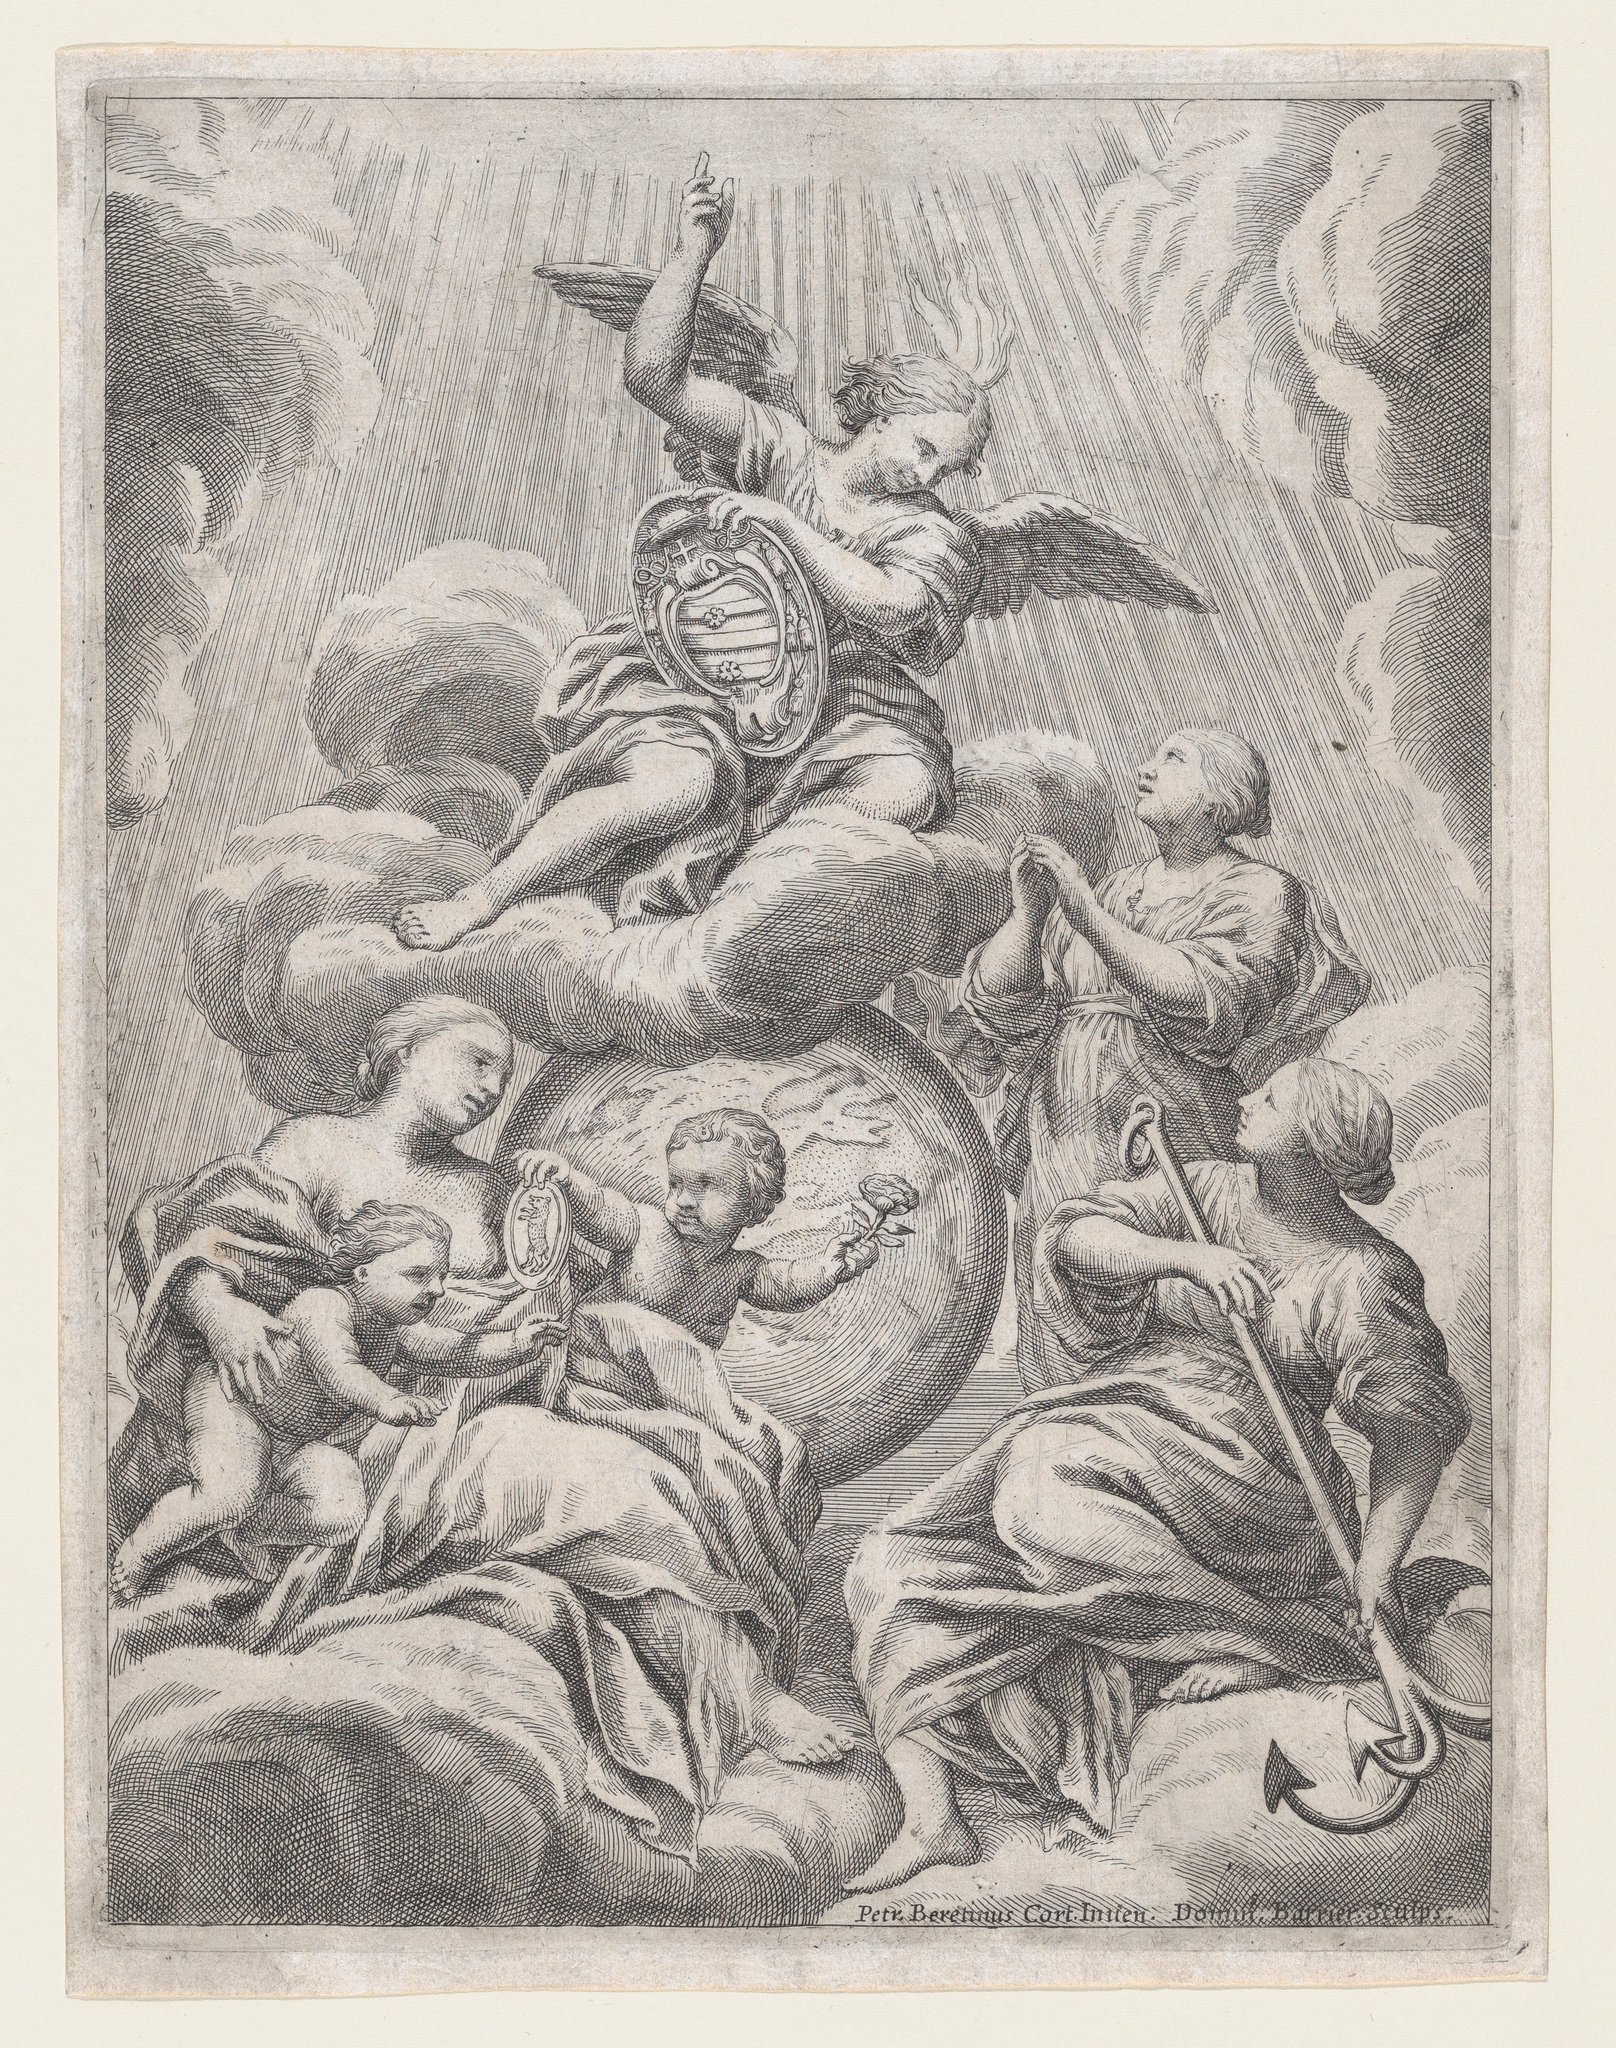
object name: print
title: Faith, Hope, and Charity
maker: dominique barrière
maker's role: artist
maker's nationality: french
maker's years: 1610-1678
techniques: engraving, etching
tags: putti,angels,globes